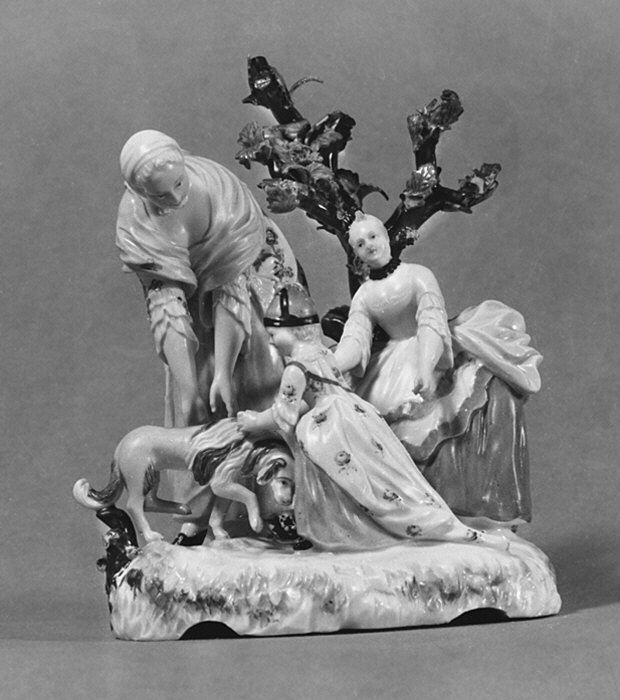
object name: group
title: Education of a Princess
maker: höchst manufactory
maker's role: manufactory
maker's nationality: german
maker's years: 1746-1796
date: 1755-1760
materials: hard paste porcelain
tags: princesses,women,dogs